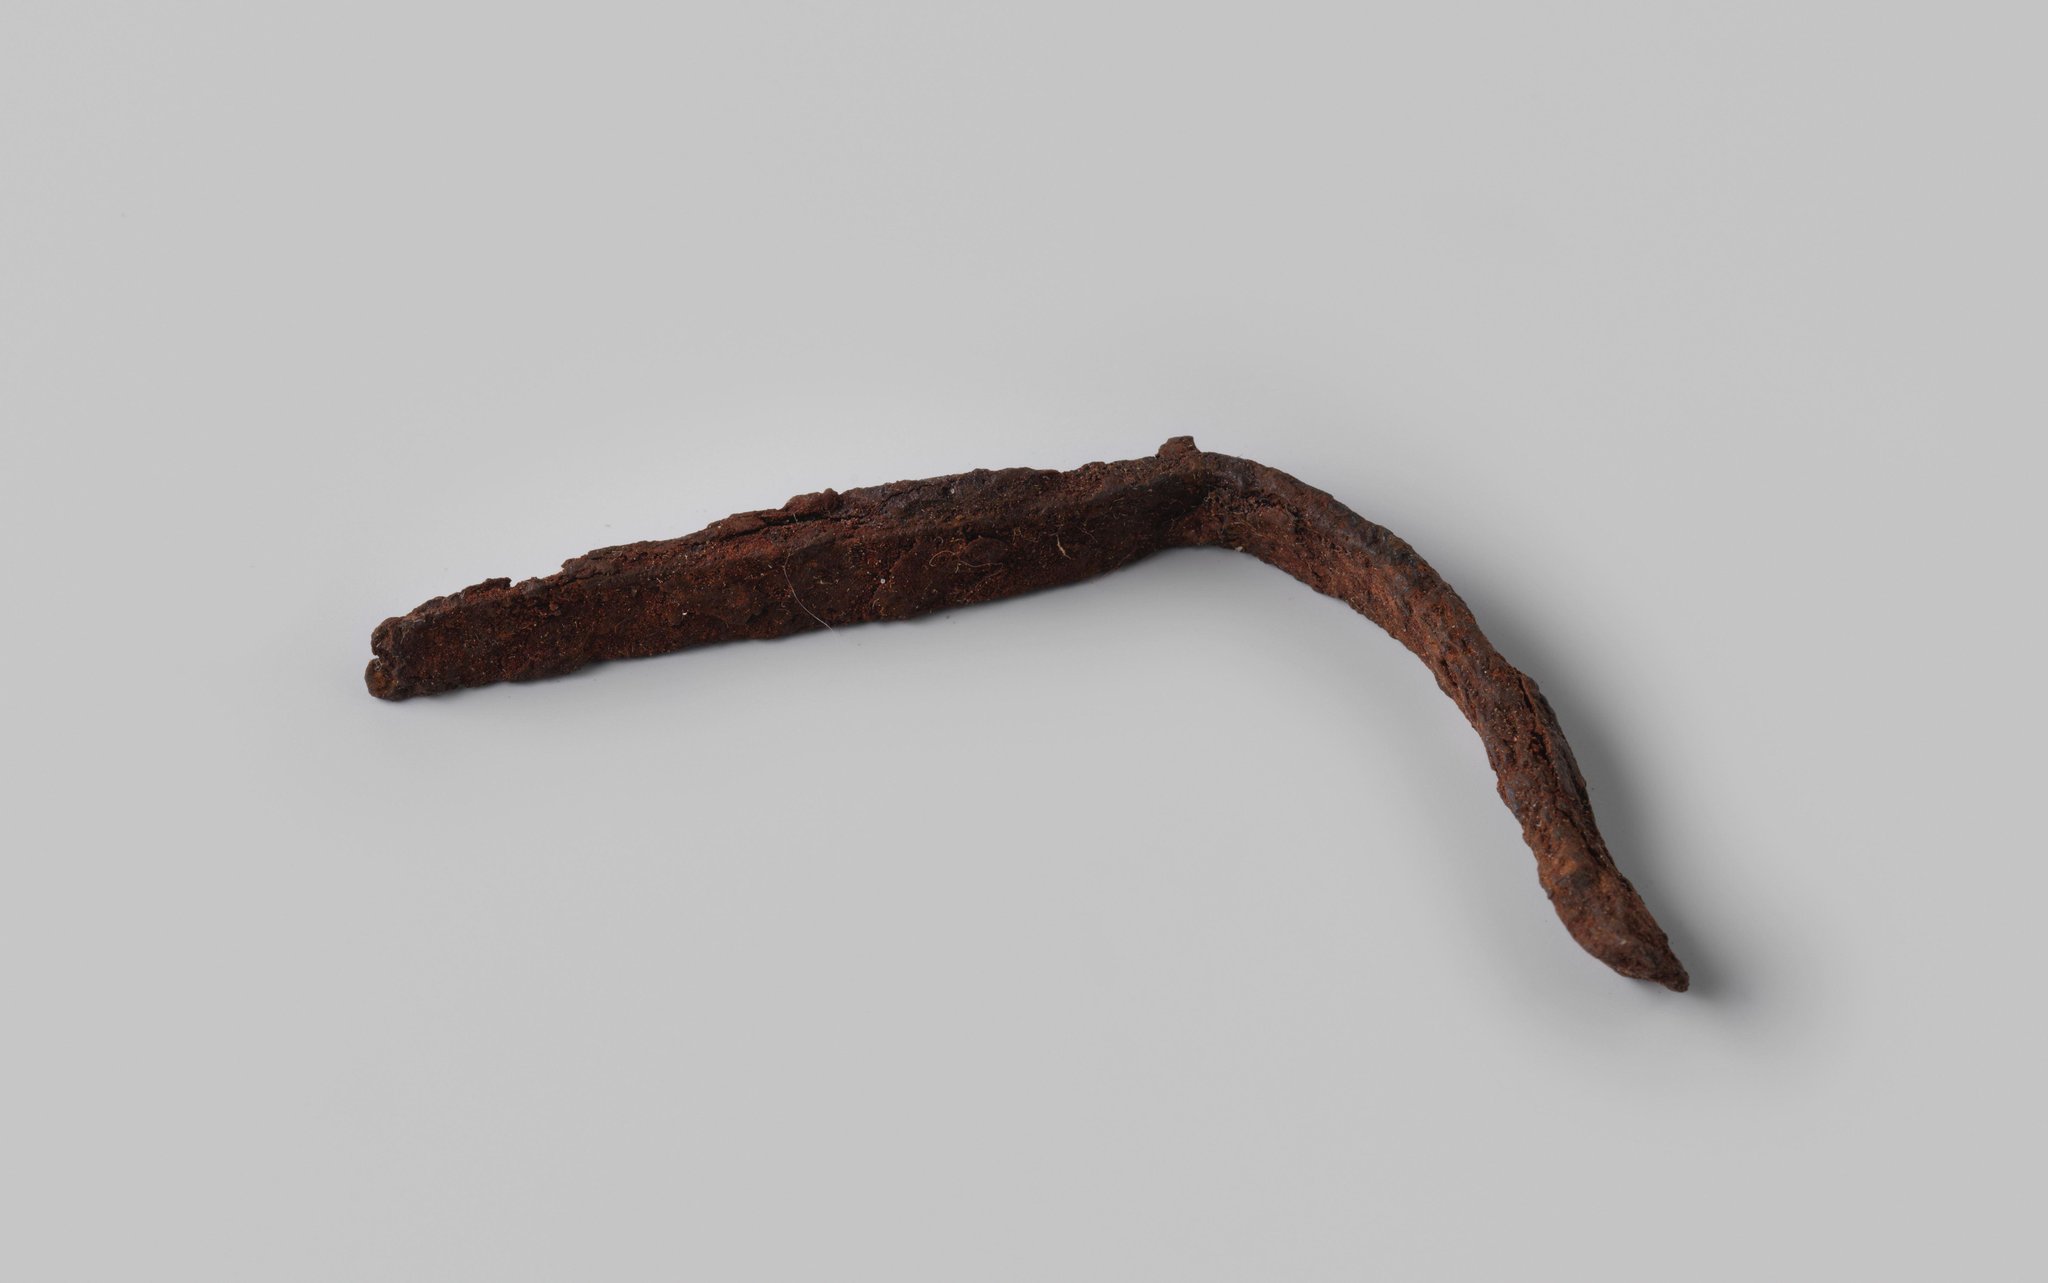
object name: fragment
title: Fragment van ijzer uit het wrak van de Oost-Indiëvaarder Hollandia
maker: Anonymous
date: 1700-1743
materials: iron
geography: netherlands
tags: verenigde oostindische compagnie, hollandia (schip), annet